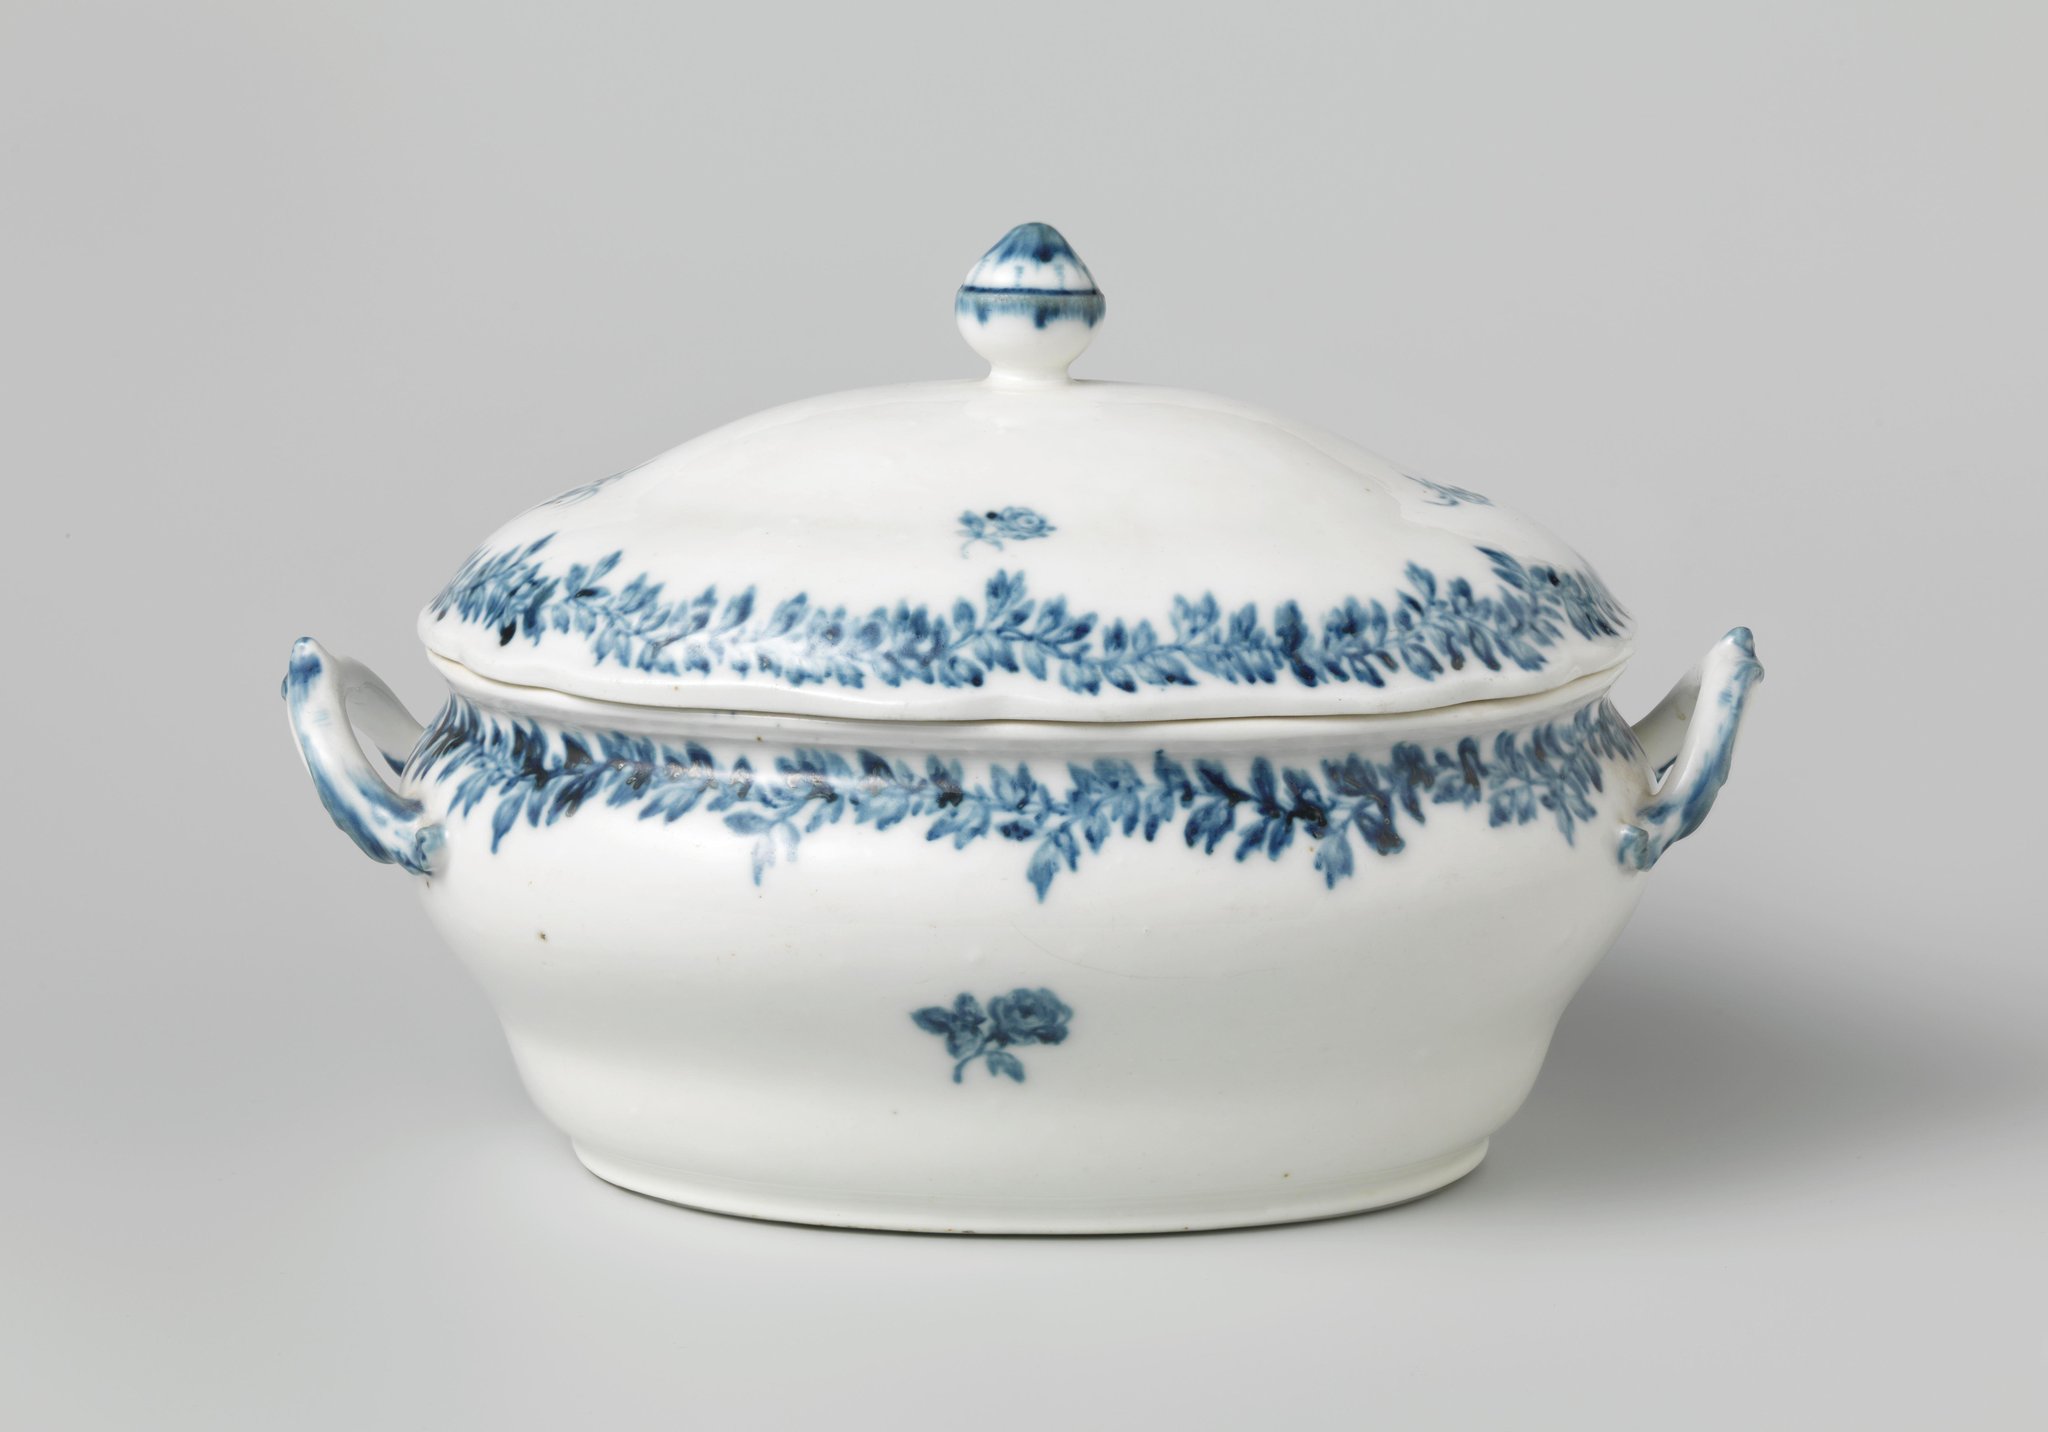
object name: tureen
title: Terrine met blad- en bloemslingers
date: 1774-1784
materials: porcelain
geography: loosdrecht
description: Terrine met deksel van porselein. Beschilderd met blauwe blad- en bloemslingers.